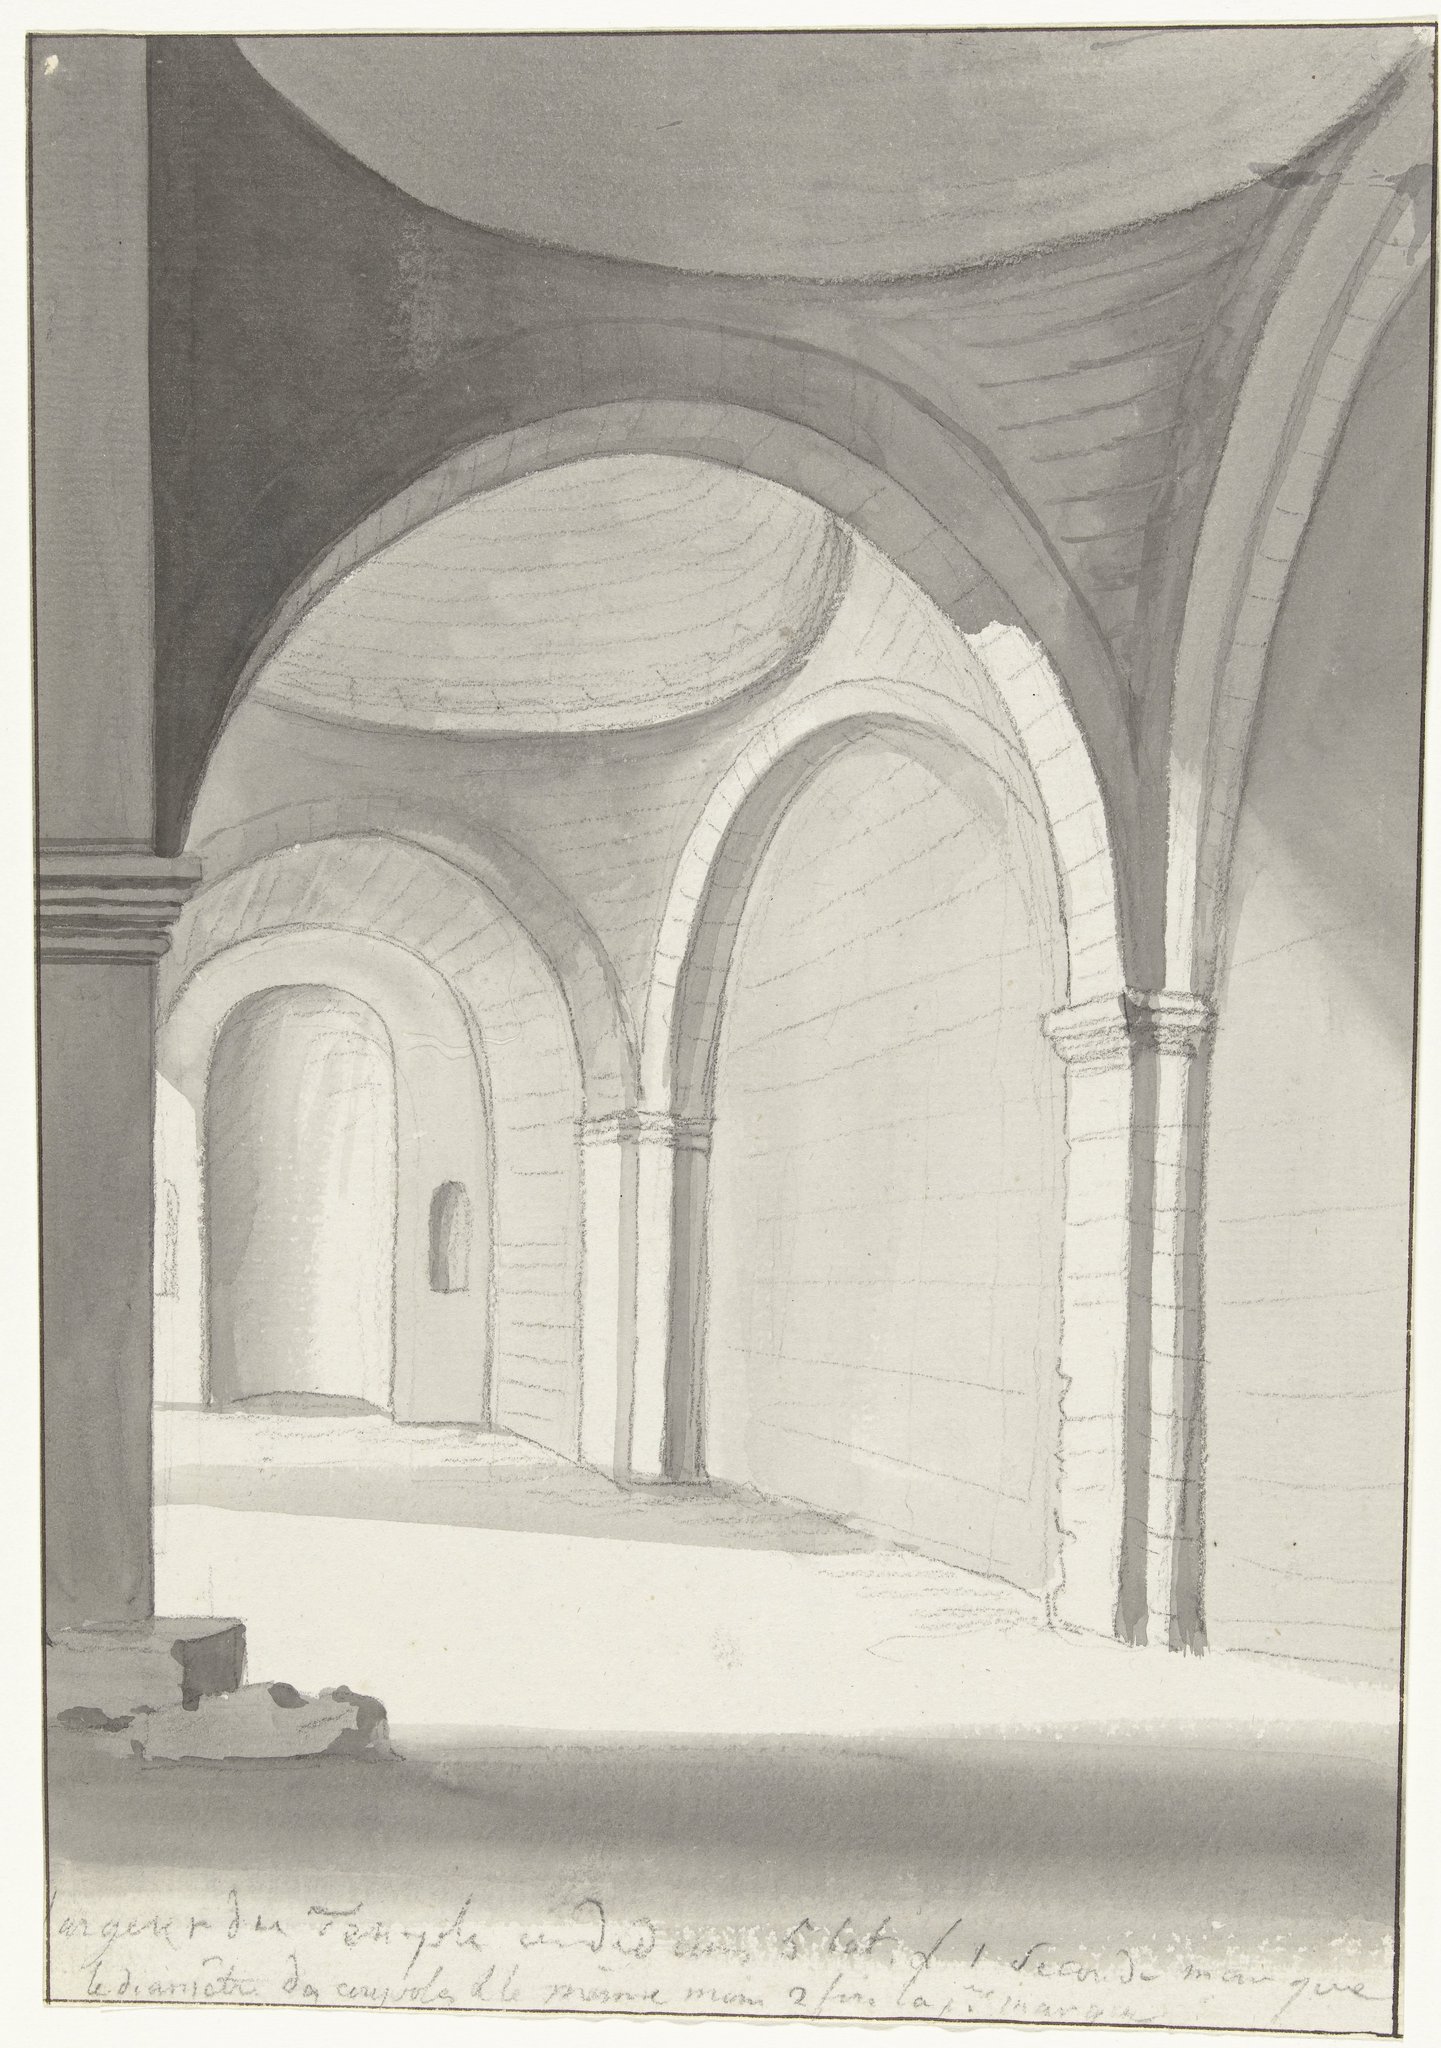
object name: drawing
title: Voyage en Italie, en Sicile et à Malte - 1778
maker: louis ducros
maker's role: draughtsman, print maker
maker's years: 1748-1810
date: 1778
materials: chalk, paper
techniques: brush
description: Tekening uit het album 'Voyage en Italie, en Sicile et à Malte', 1778.